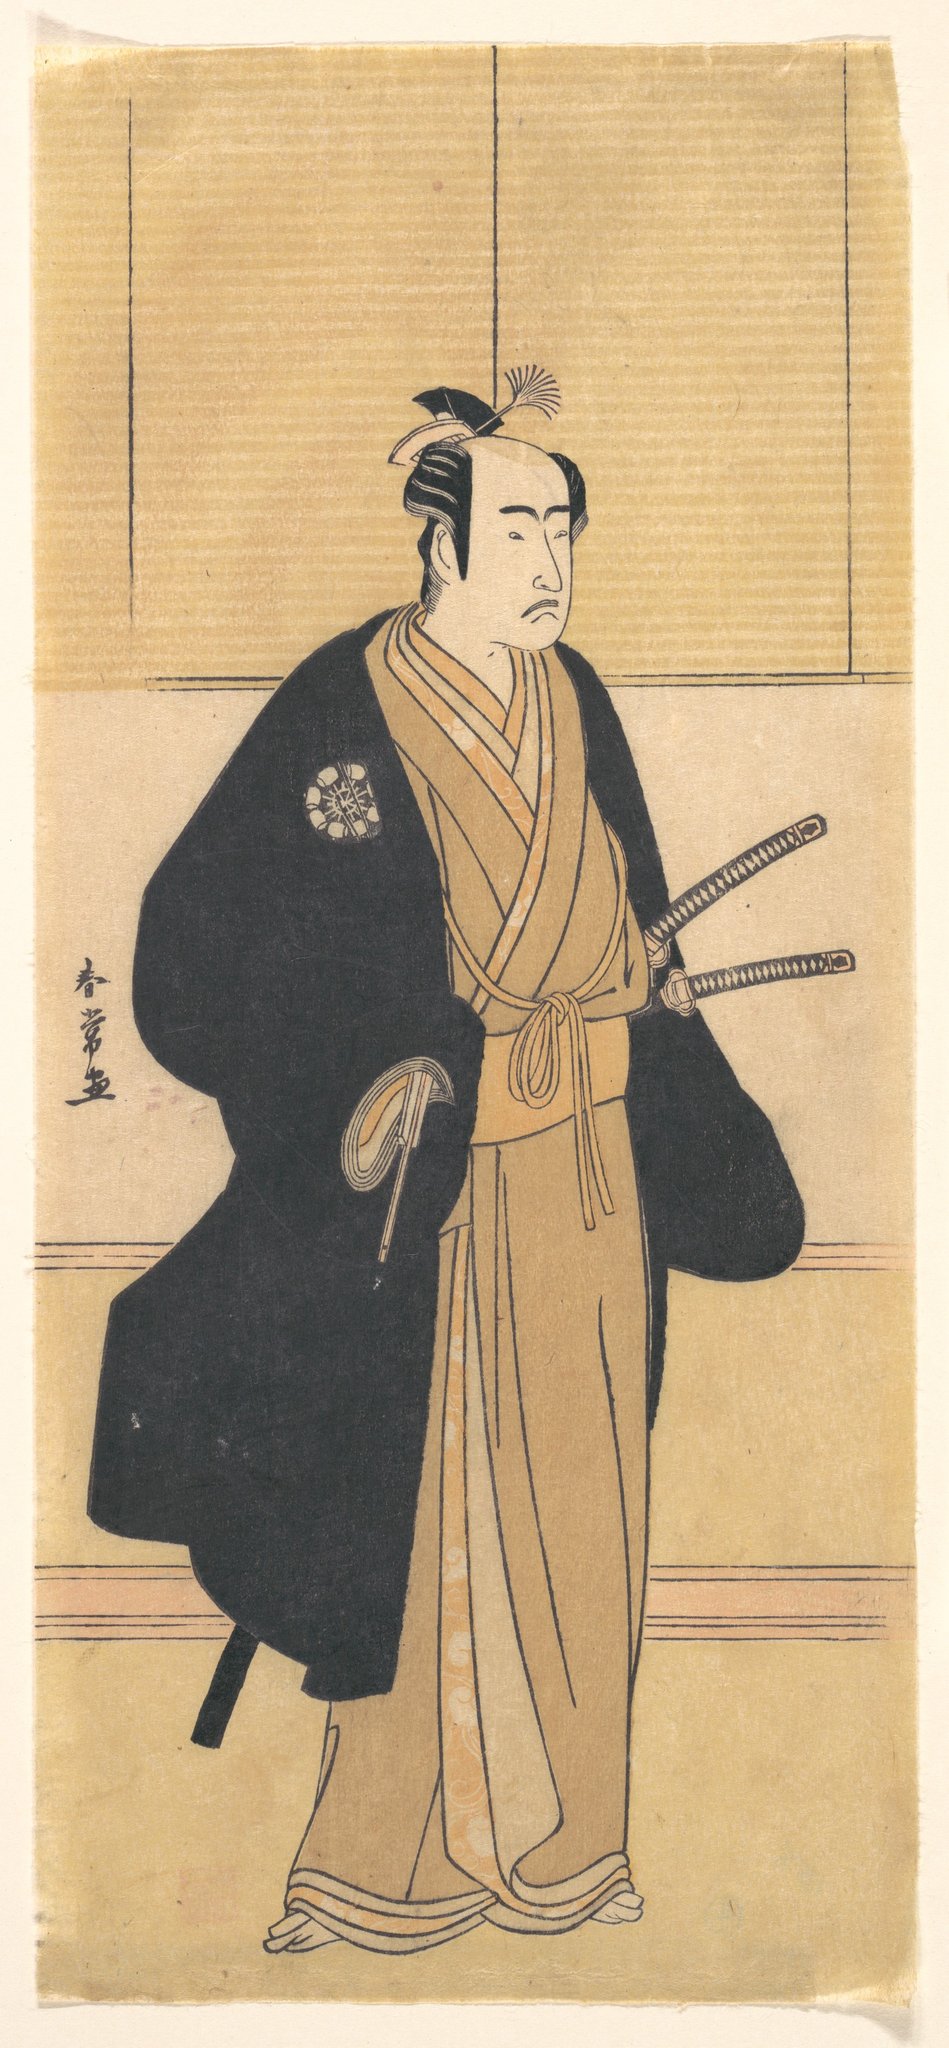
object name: print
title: An Unidentified Actor in the Role of a Samurai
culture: japanese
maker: katsukawa shunjō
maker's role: artist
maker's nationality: japanese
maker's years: 1700-1787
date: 1700-1787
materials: ink, paper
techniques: woodblock print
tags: men,actors